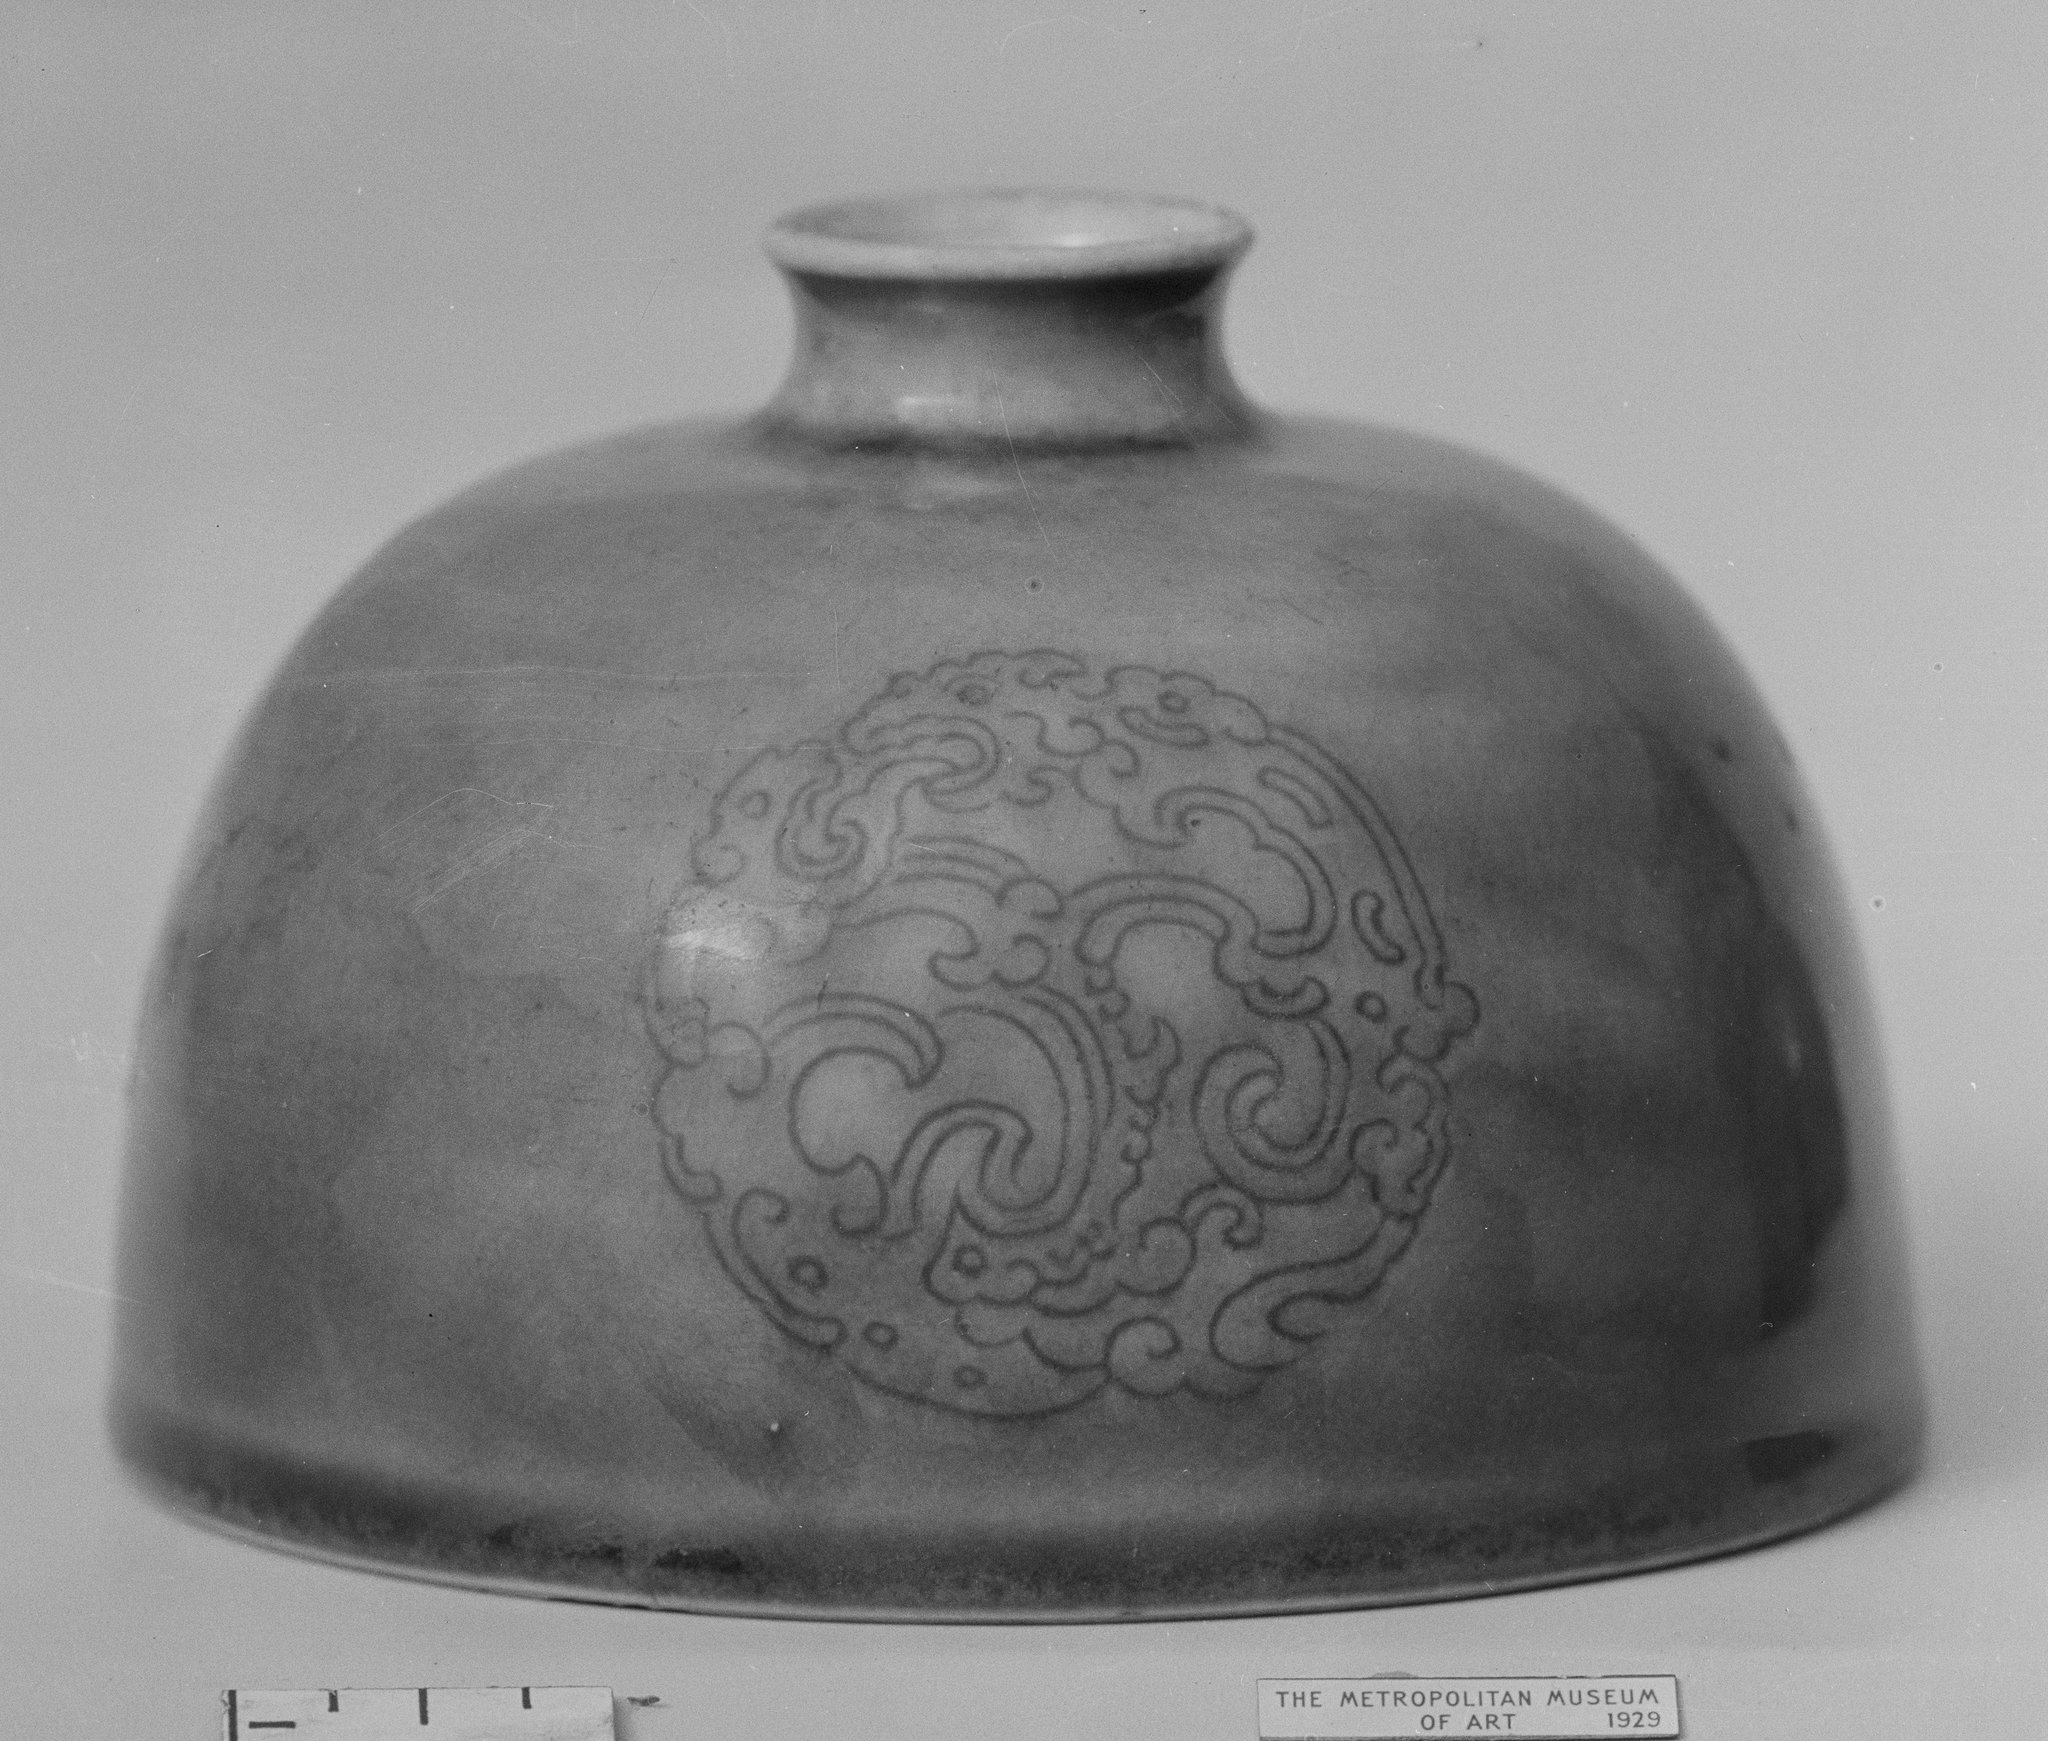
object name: water coupe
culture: chinese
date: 1662-1722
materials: glaze, porcelain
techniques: incising